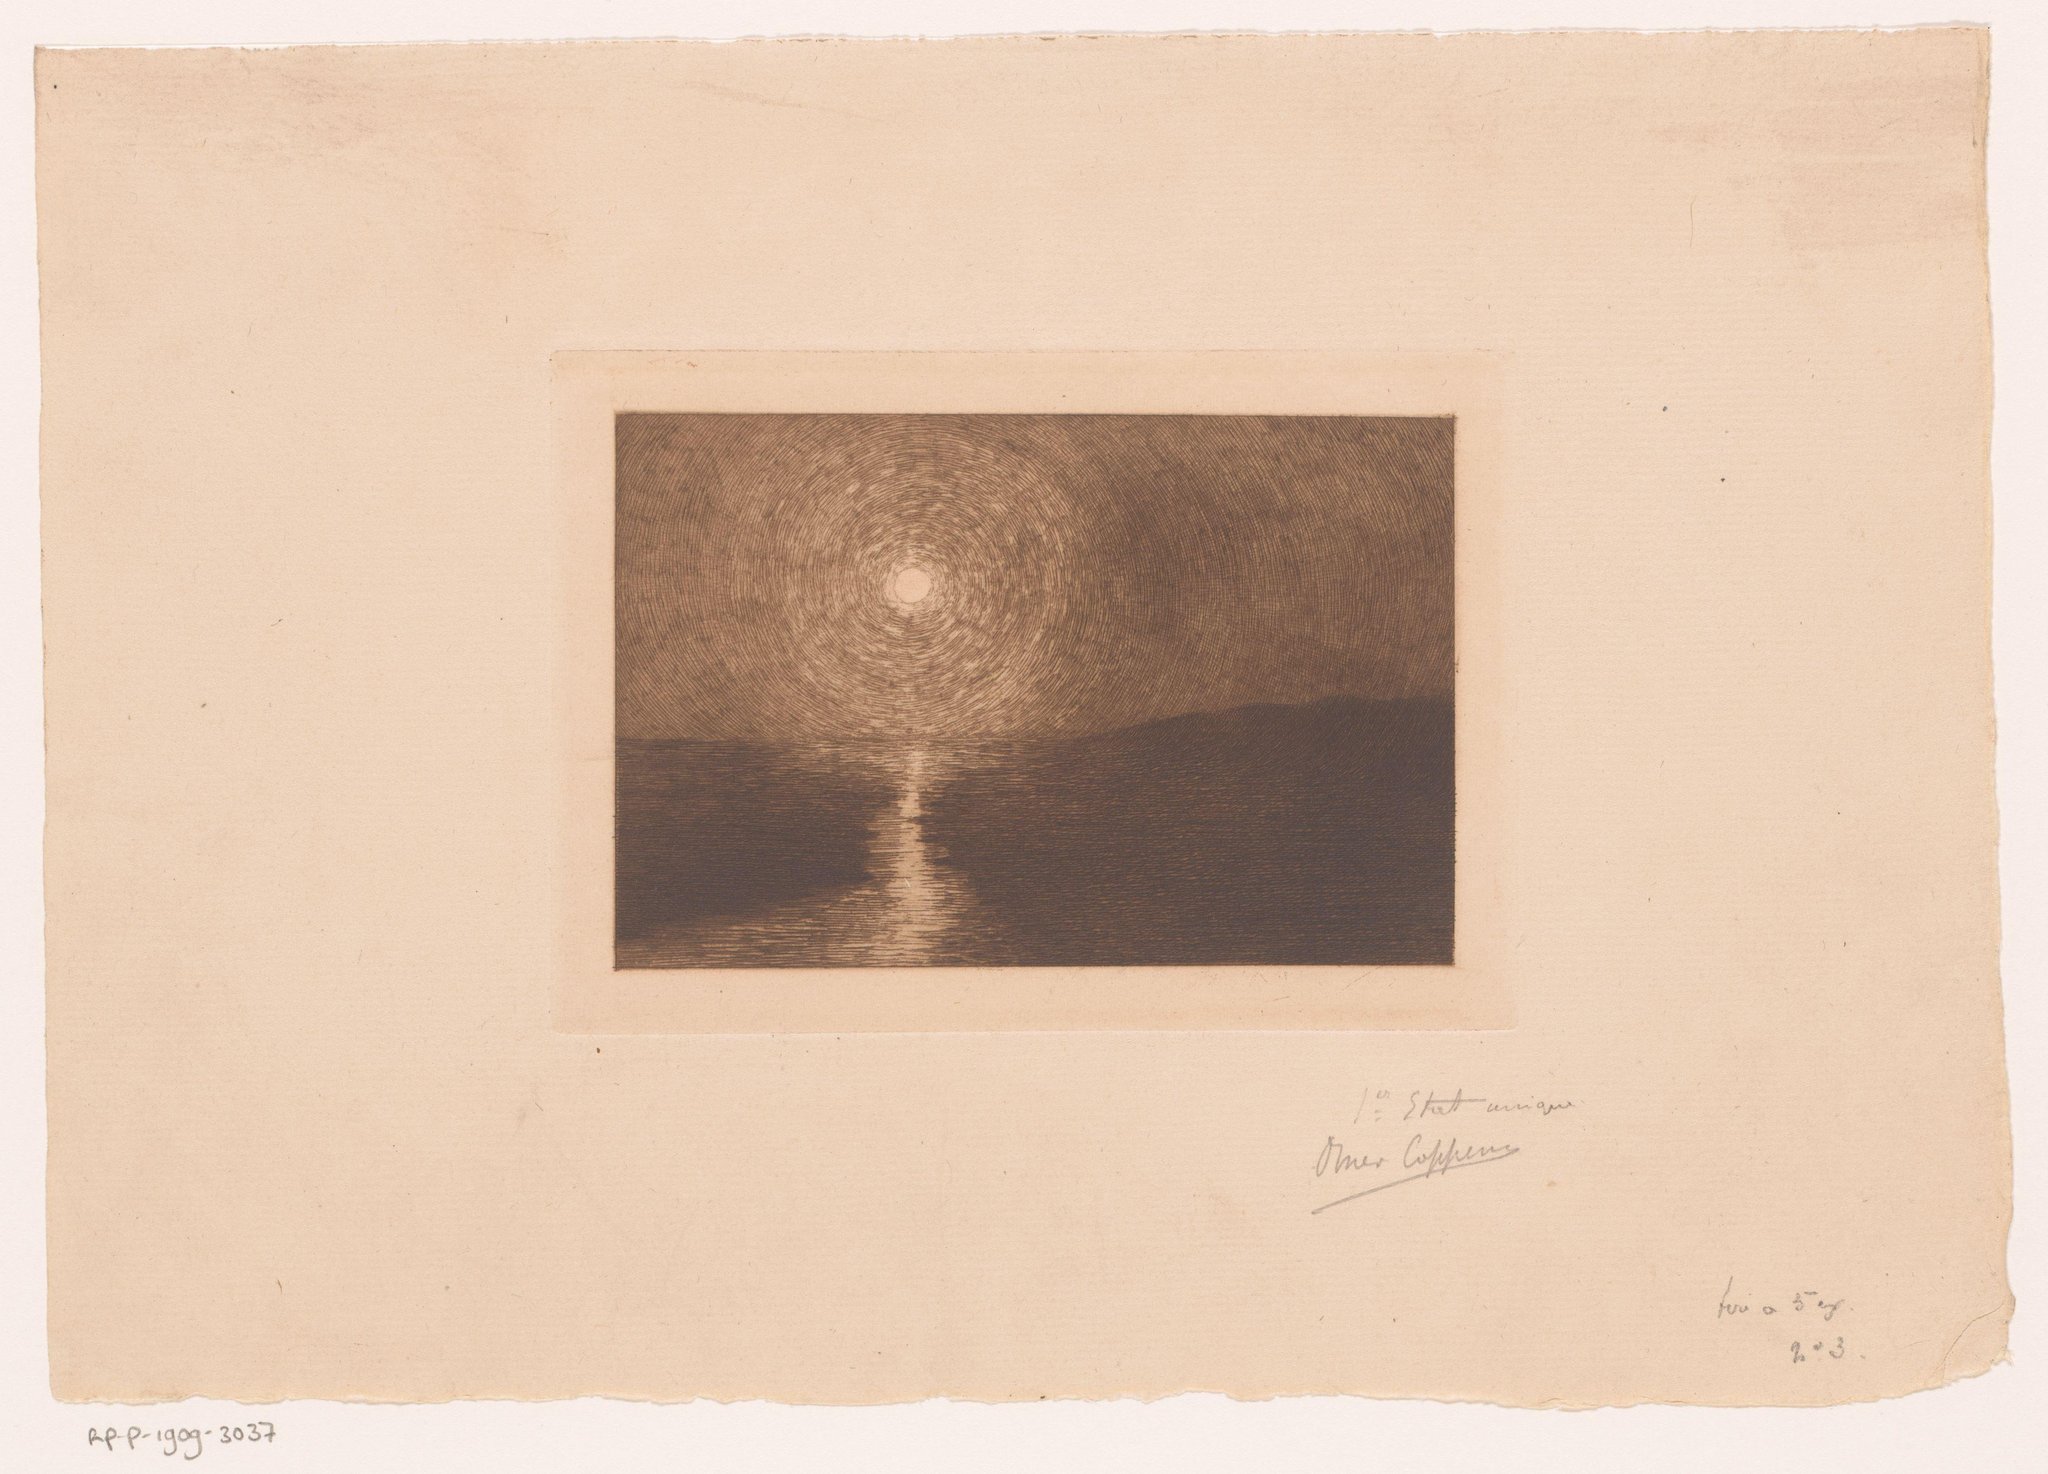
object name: print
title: Zee bij maneschijn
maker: omer coppens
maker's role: print maker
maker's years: 1864-1926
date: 1874-1909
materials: paper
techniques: etching, intaglio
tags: moonlight, sea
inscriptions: inscription: ‘1em Etat unique’, collector's mark: Lugt 2228, inscription: ‘8 effet du clair de lune sur la mer’